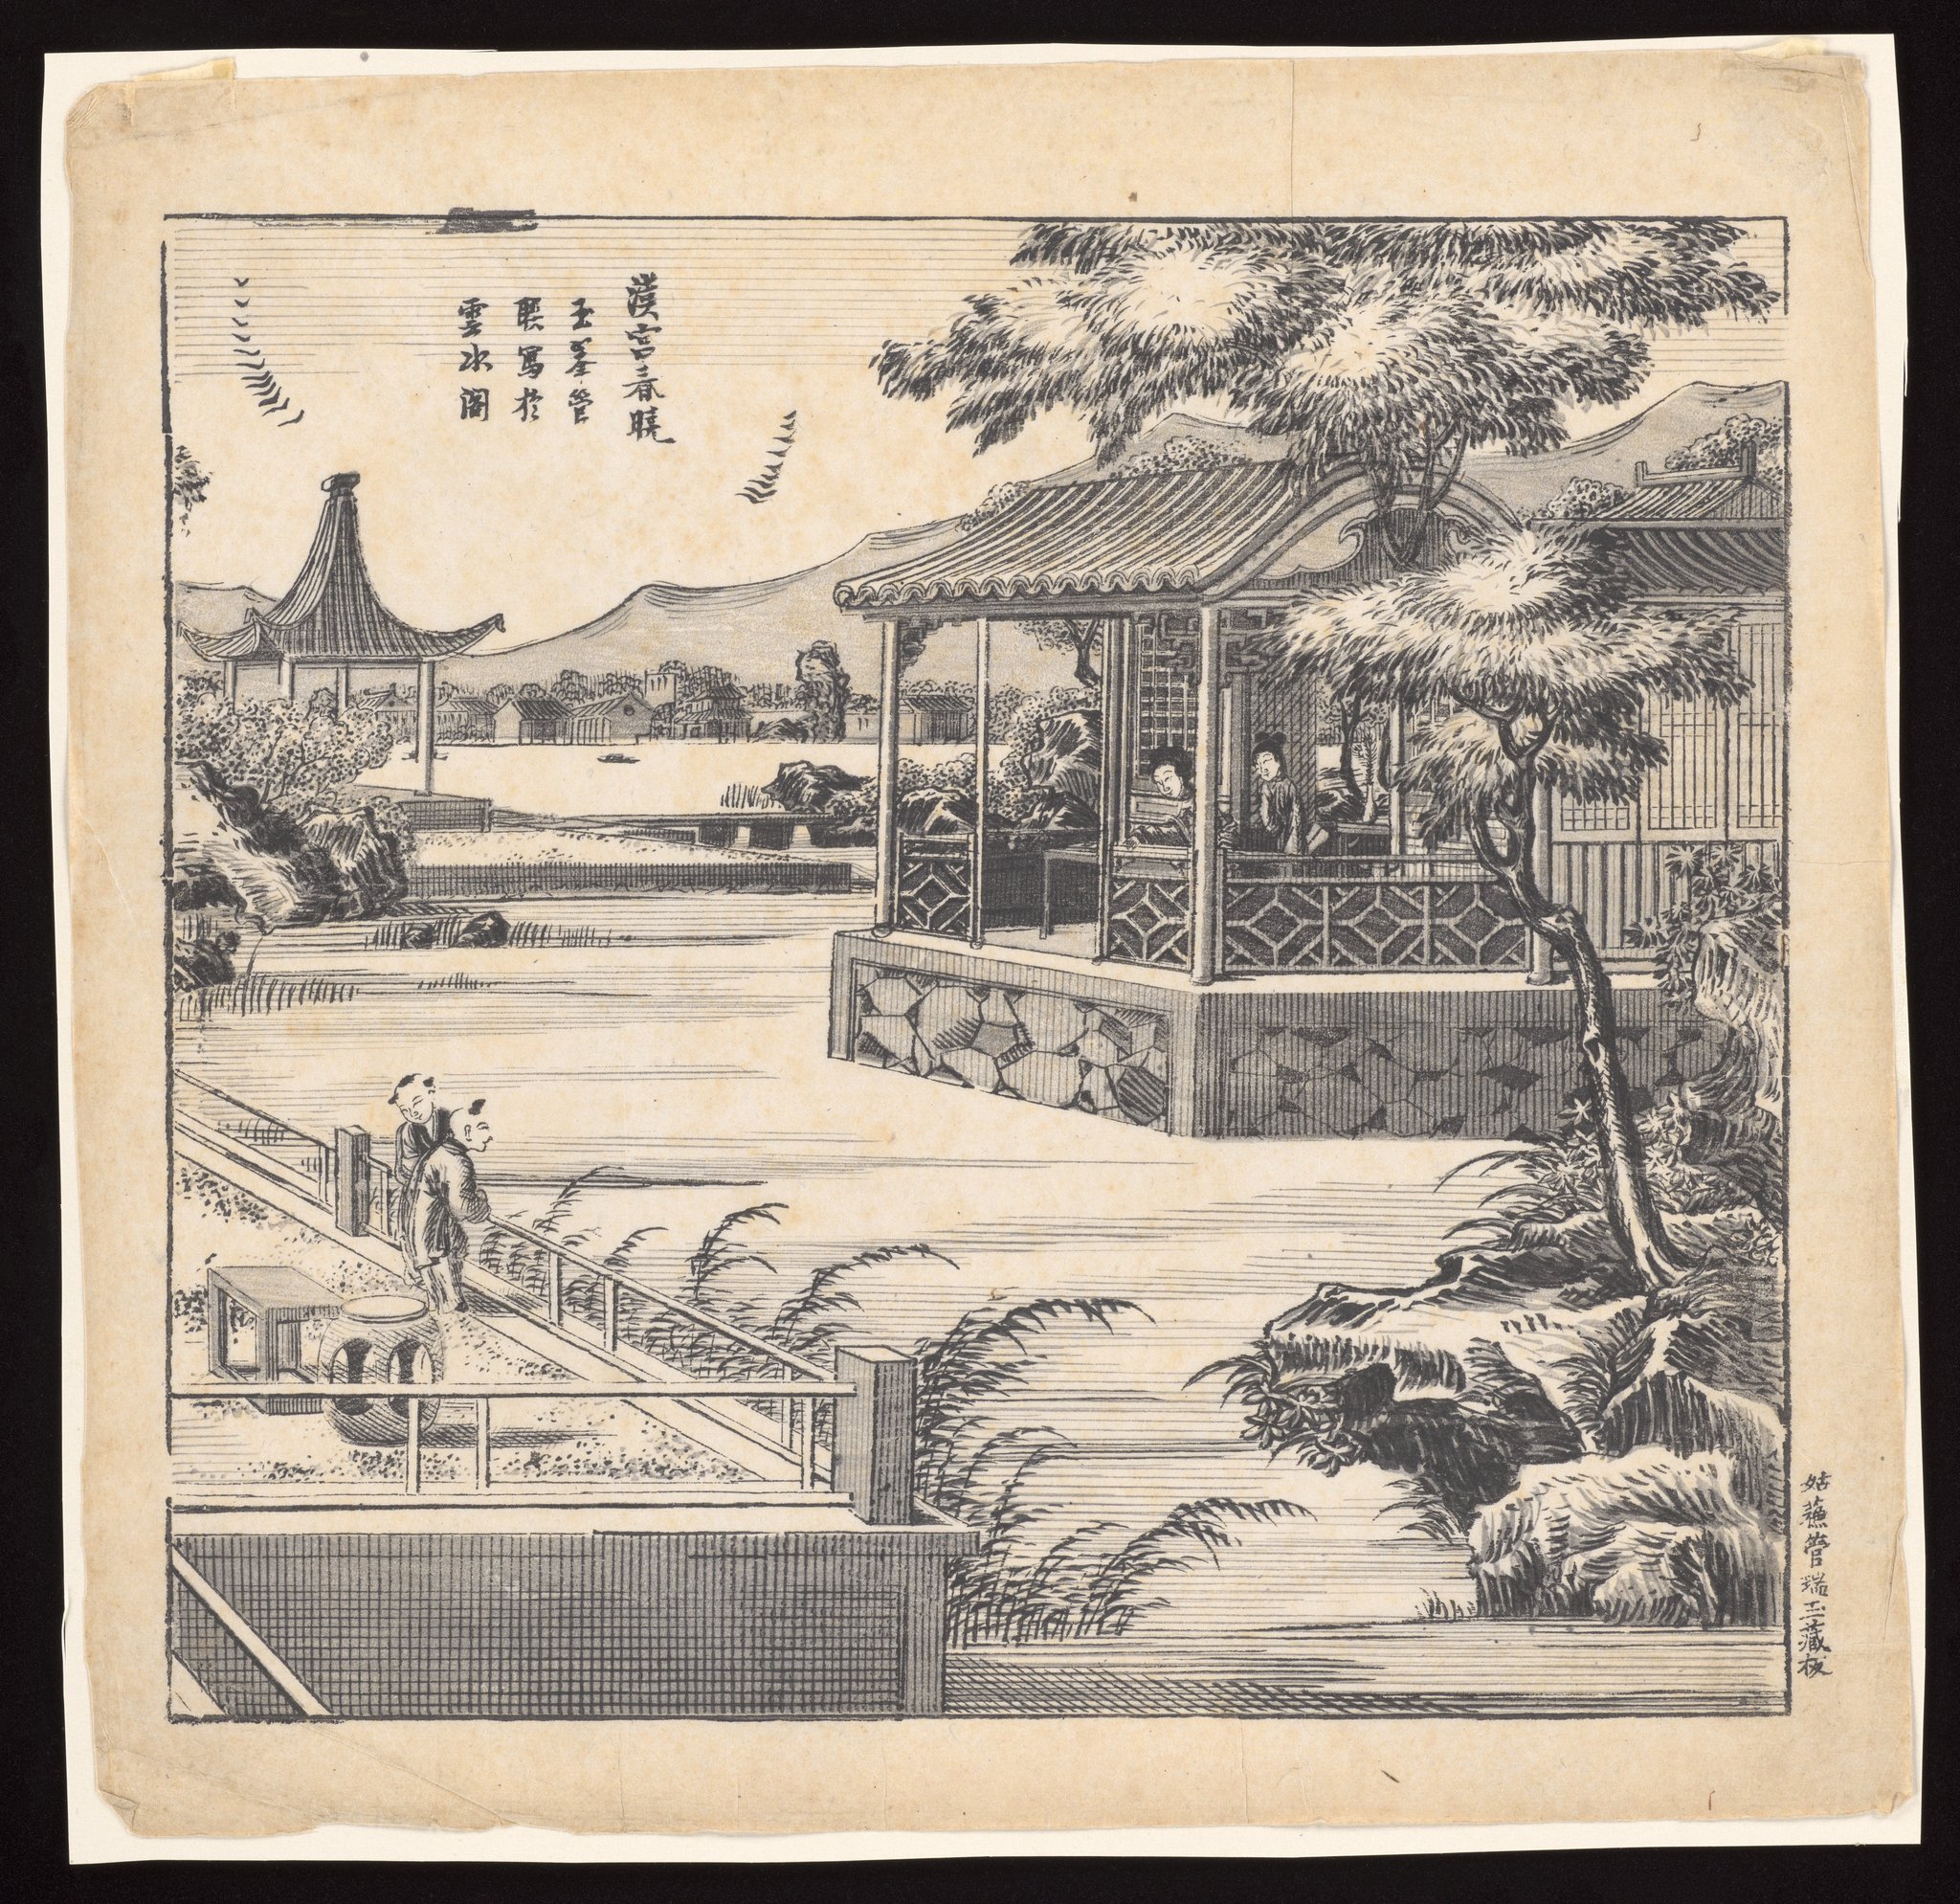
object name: print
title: Spring Morning in the Han Palace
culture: chinese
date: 1736-1795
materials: ink, paper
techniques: woodblock print